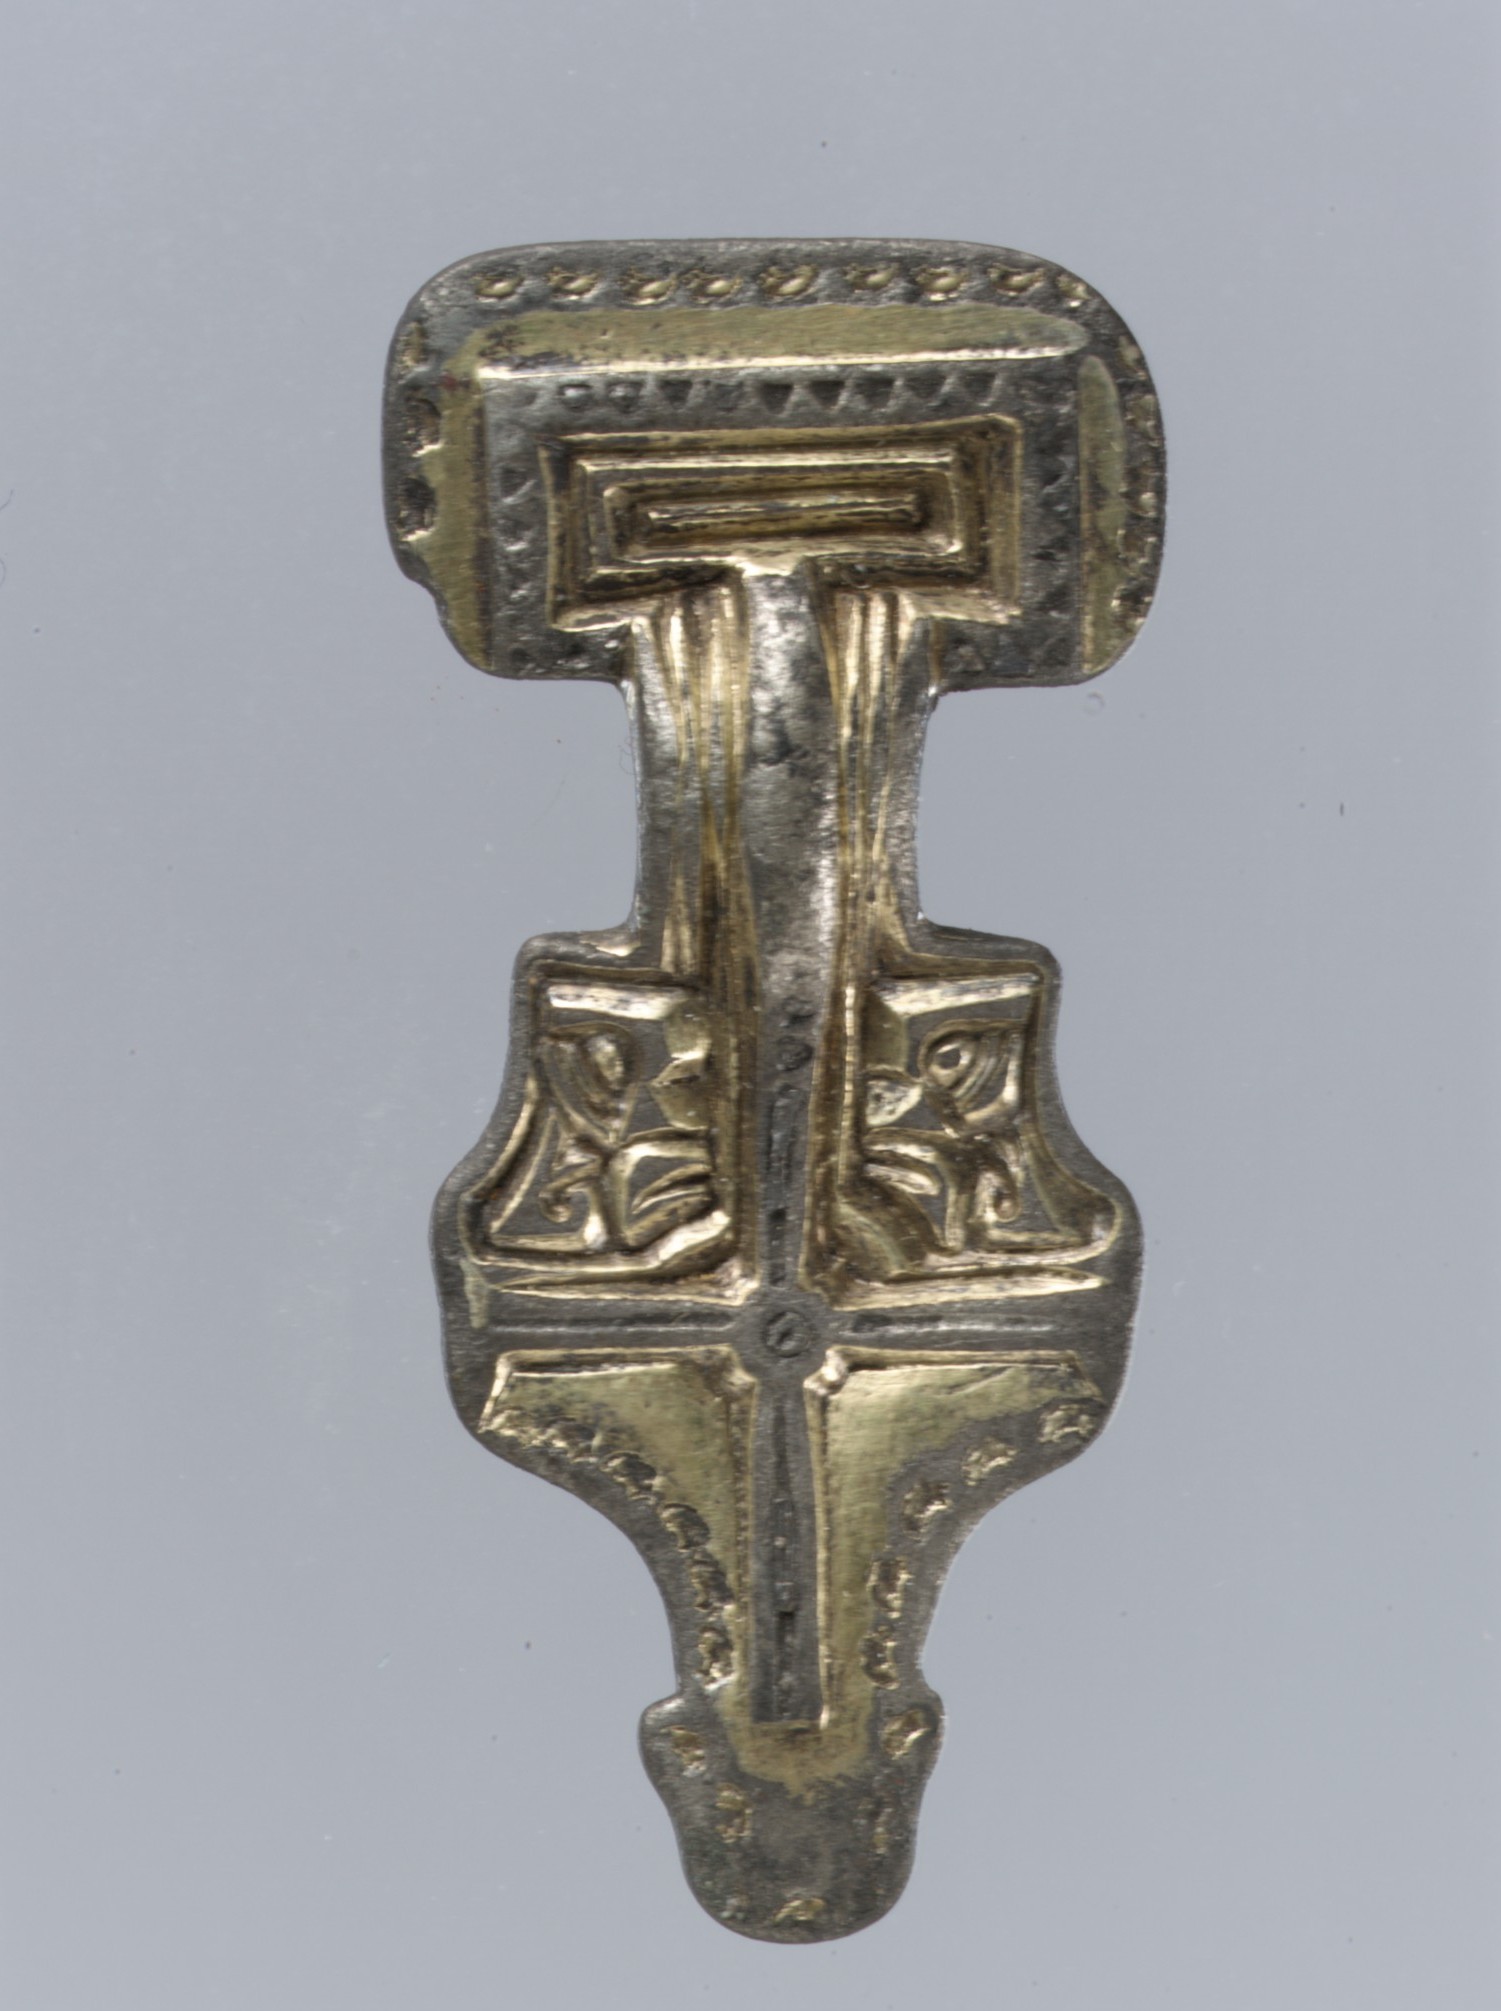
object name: brooch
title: Miniature Square-Headed Brooch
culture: anglo-saxon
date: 501-550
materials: iron, niello, silver gilt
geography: england